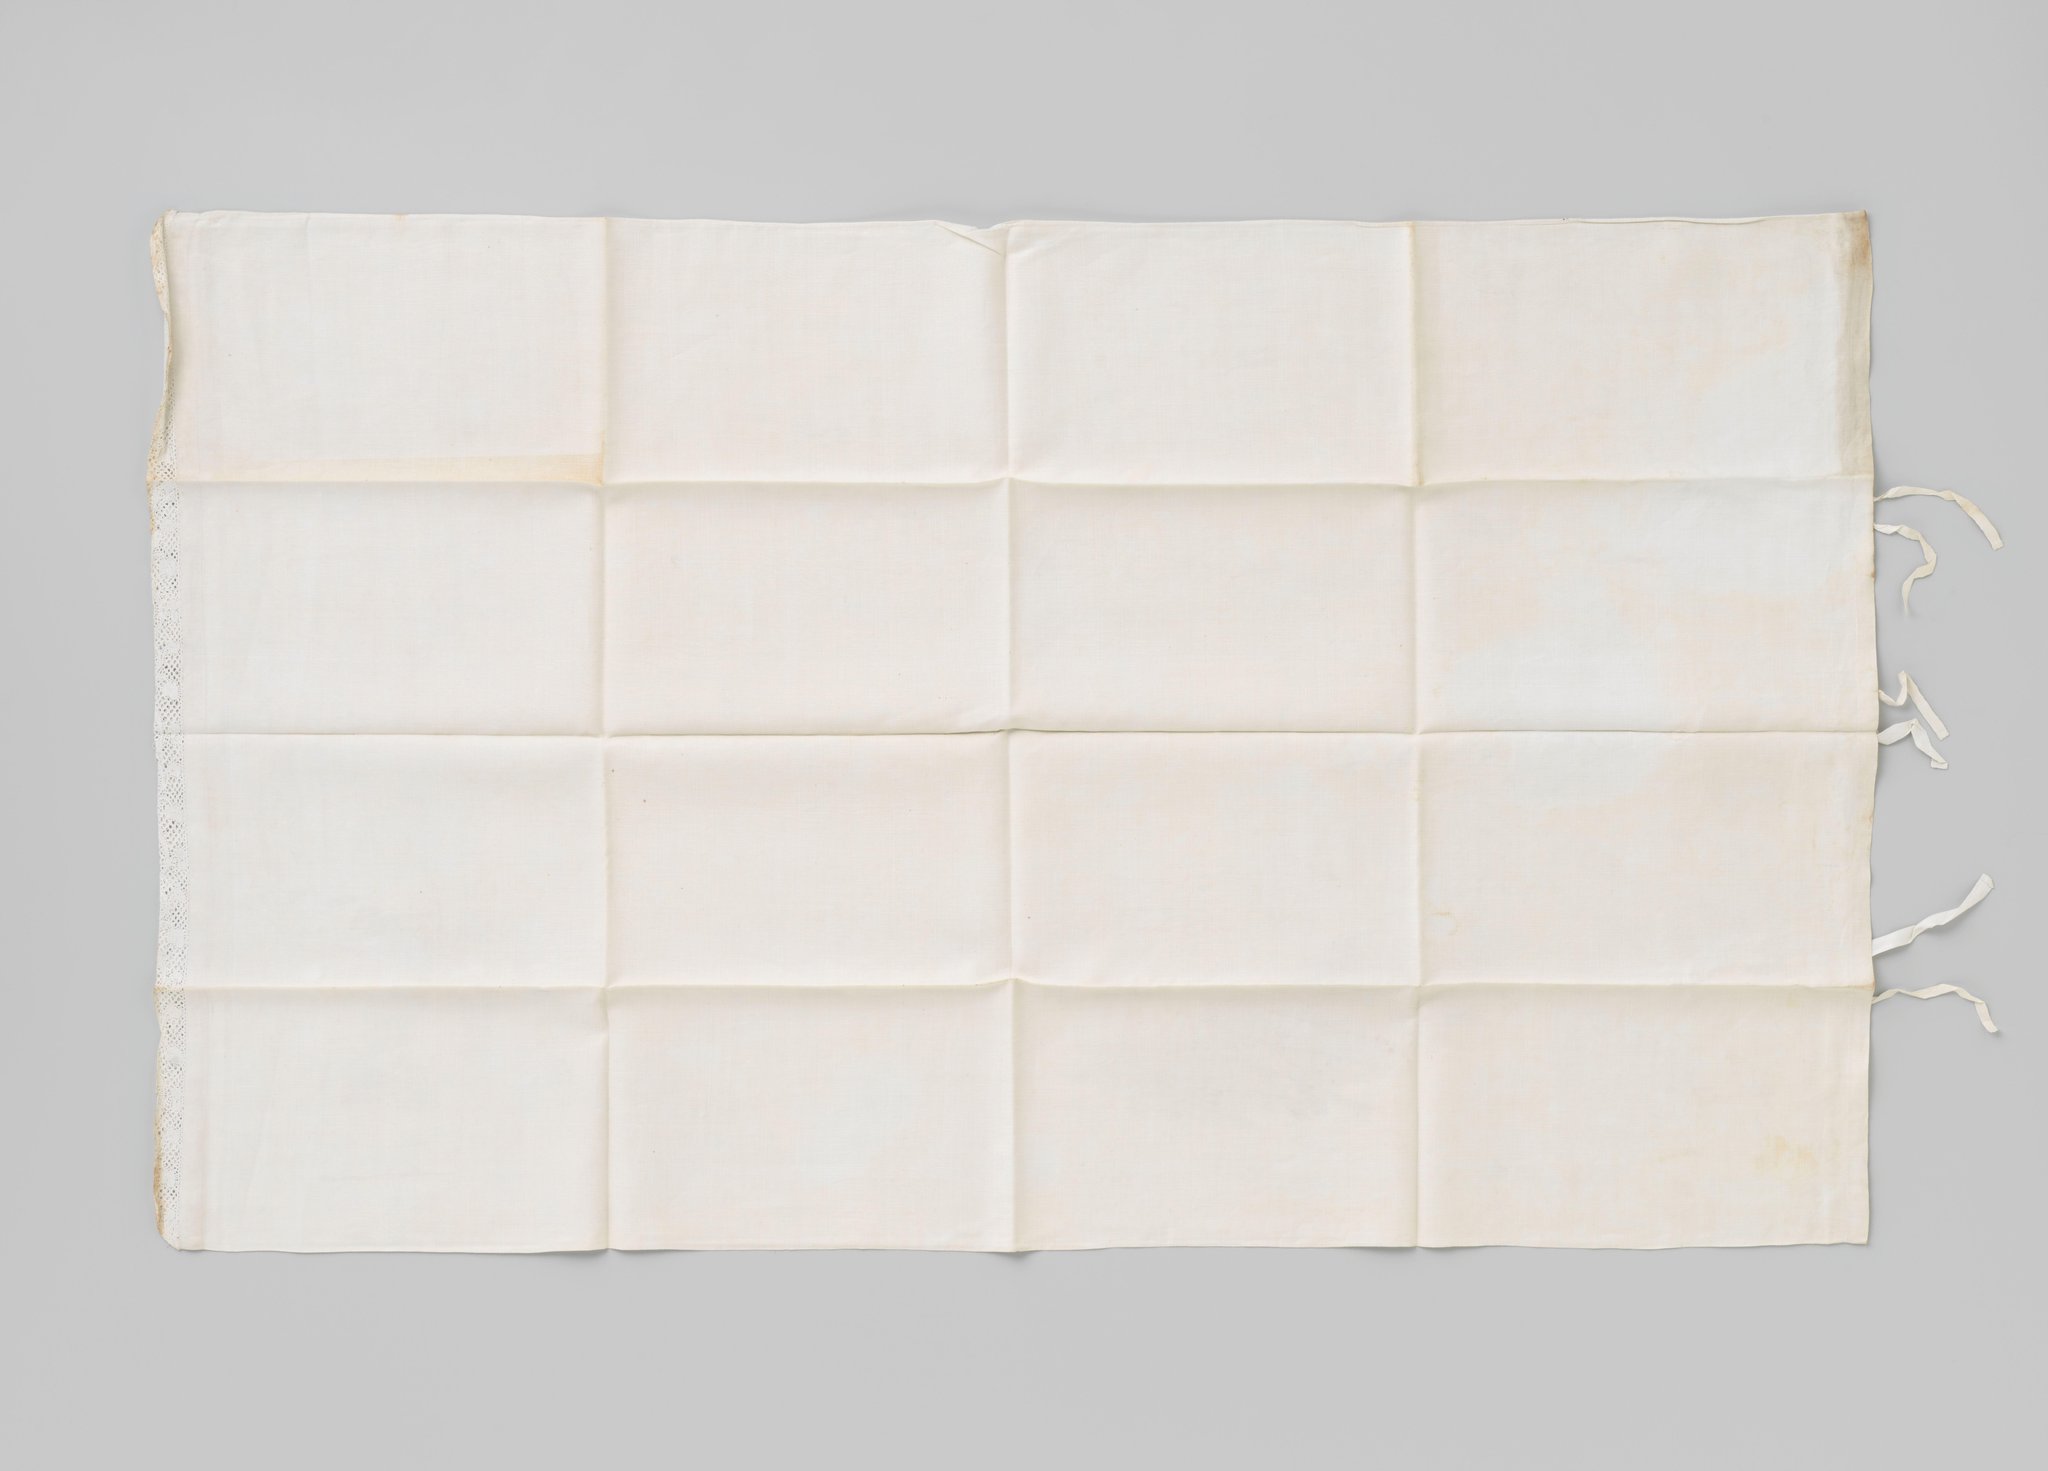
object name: sloop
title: Kussensloop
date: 1692-1735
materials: linen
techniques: lace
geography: northern netherlands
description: Kussensloop van linnen met aan een uiteinde kloskant. Gemerkt kroon GS.